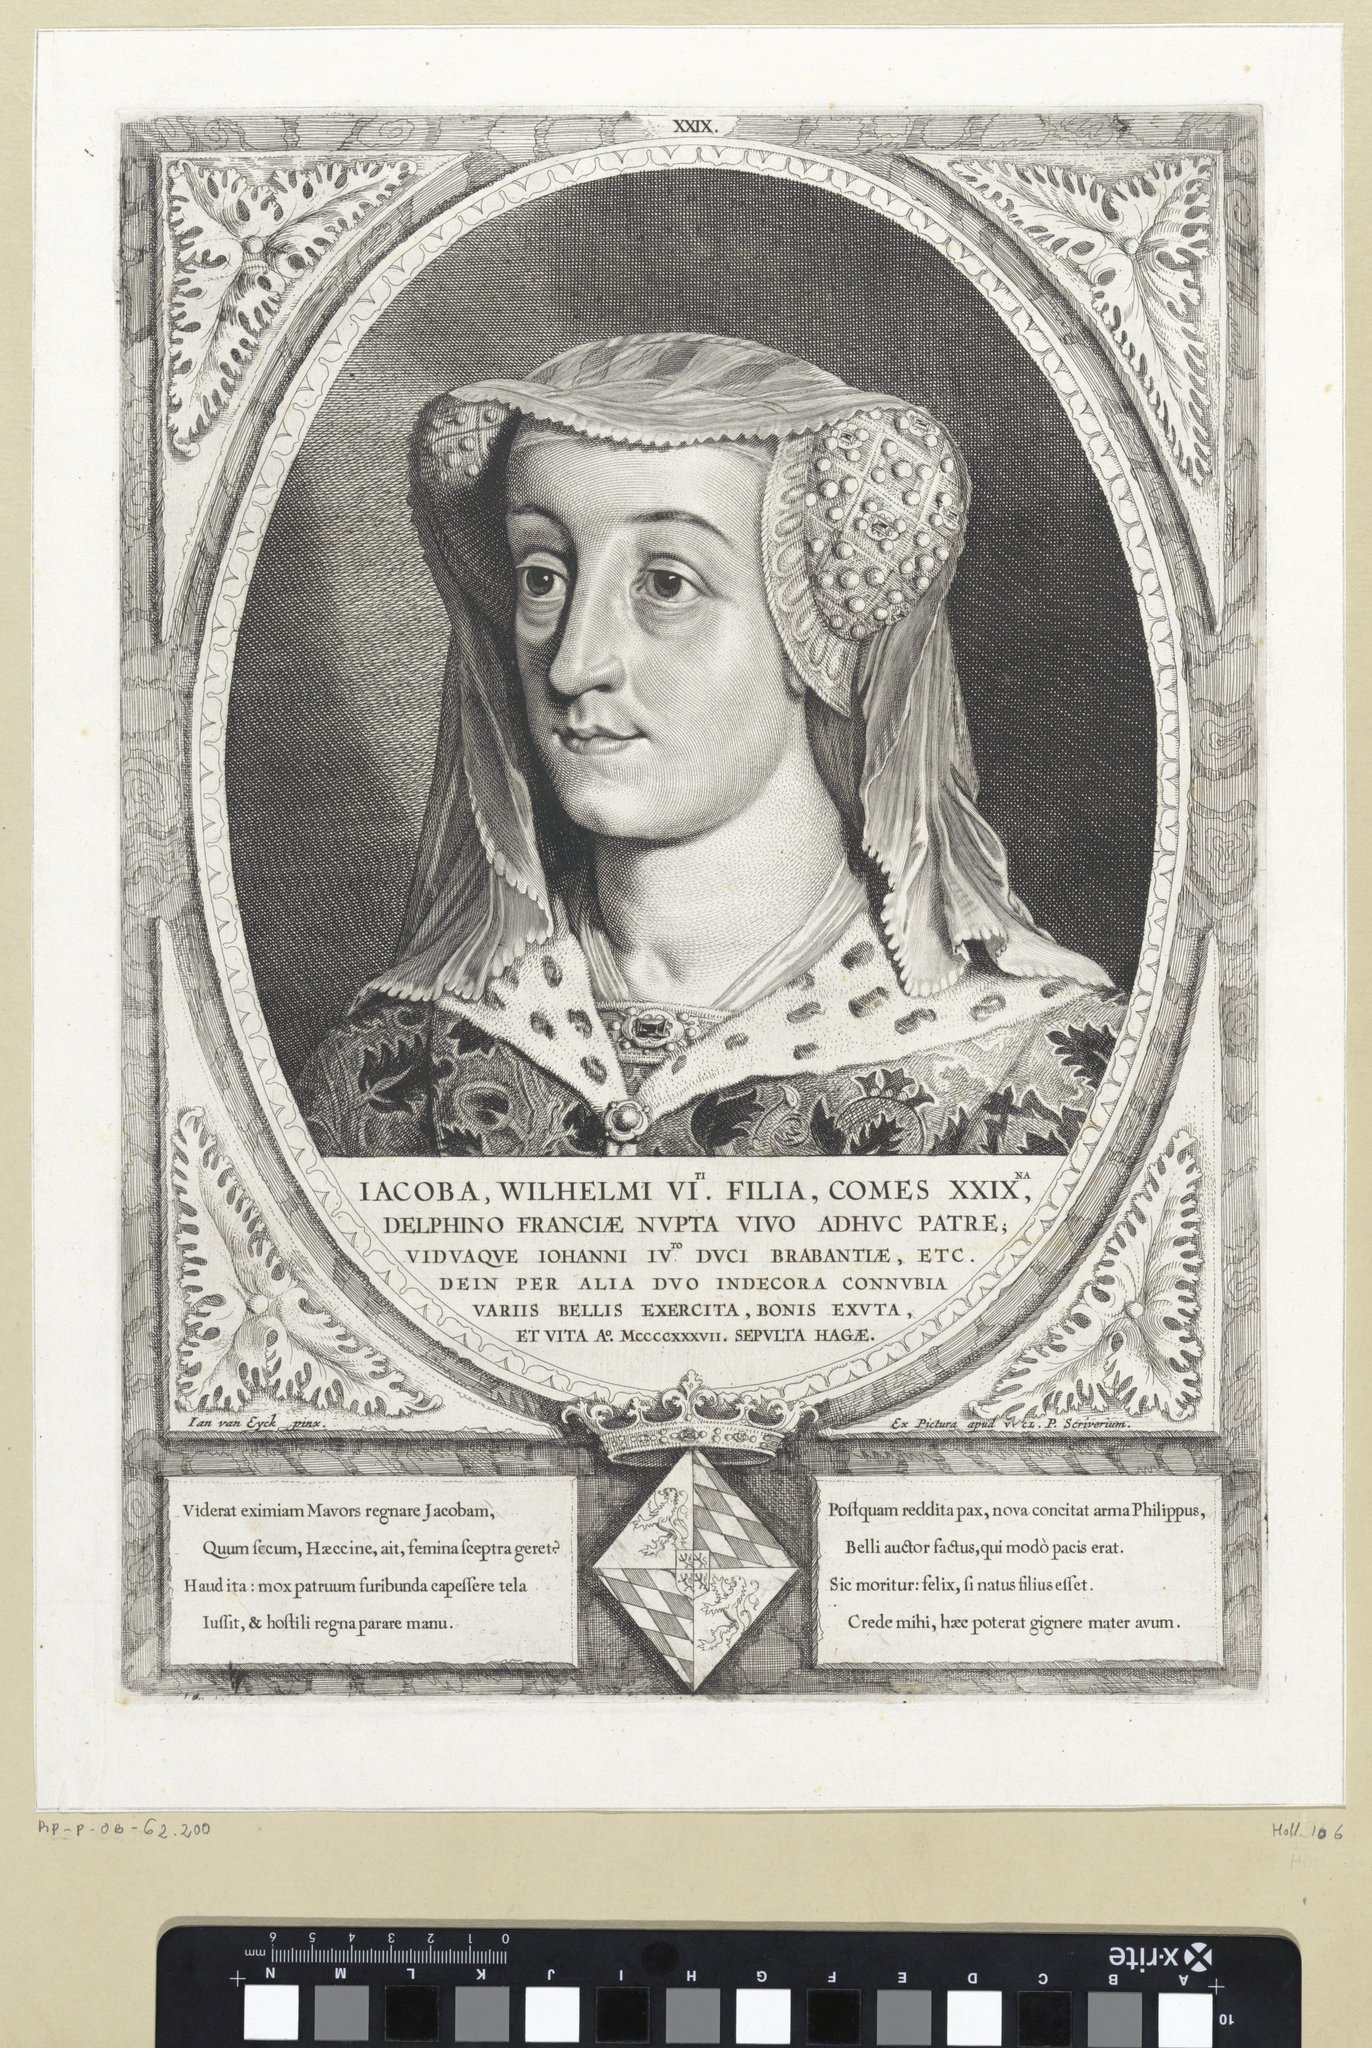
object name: print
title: Graven en gravinnen van Holland, Zeeland en West-Friesland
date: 1650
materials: paper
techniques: engraving, etching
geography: haarlem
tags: jacoba of bavaria (countess of hainaut), nobility and patriciate; chivalry, knighthood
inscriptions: collector's mark: Lugt 12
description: Jacoba van Beieren, gravin van Holland, Zeeland en Henegouwen. Ze draagt een sluier en een hoofdtooi, versierd met parels en edelstenen. Prent uit een serie van 38 prenten met portretten ten voeten uit van graven en gravinnen van Holland.